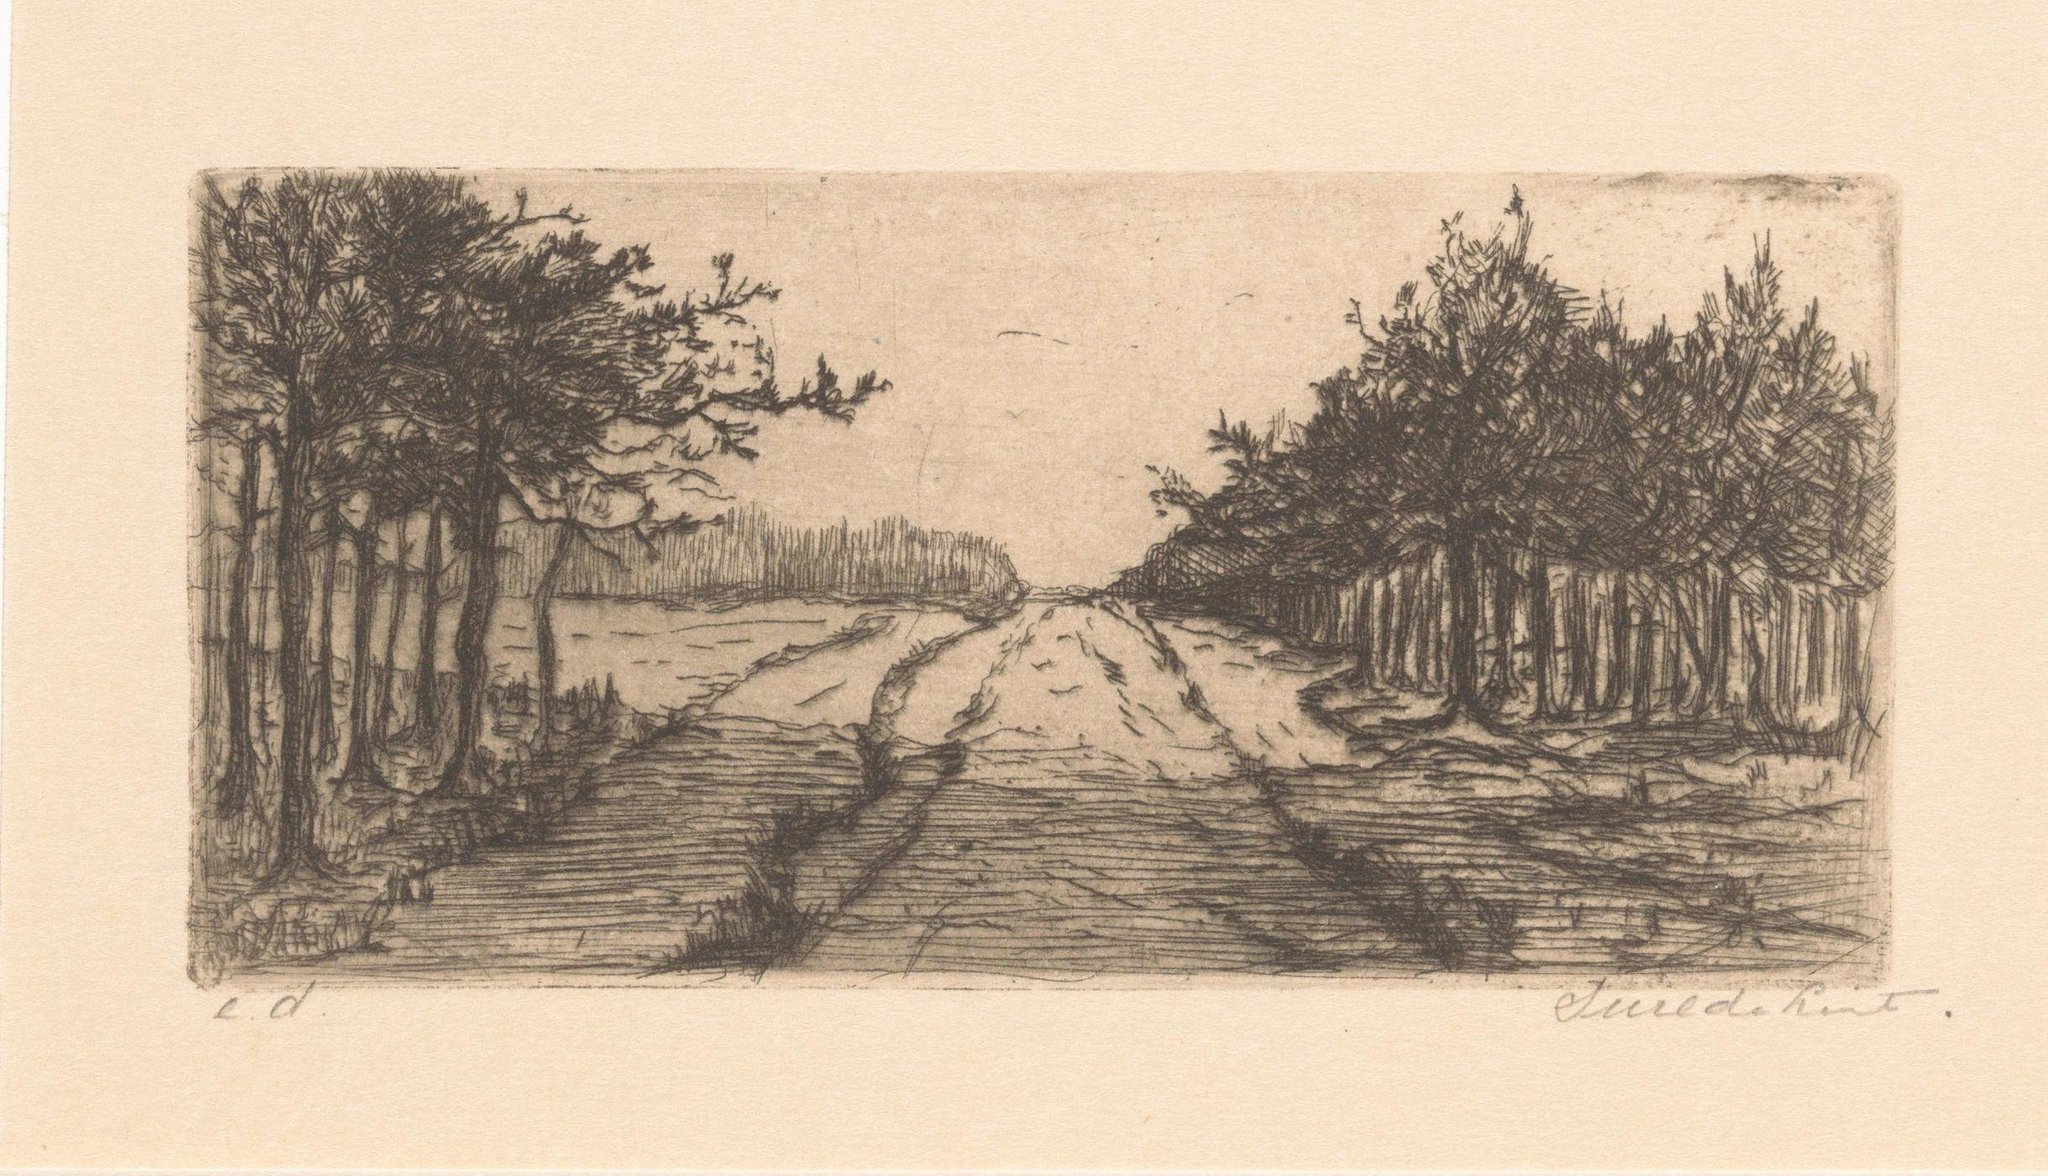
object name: print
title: Landweg bij bosrand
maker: suze de lint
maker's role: print maker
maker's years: 1878-1953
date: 1888-1931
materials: paper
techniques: etching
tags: fringe, edge of the wood, road, path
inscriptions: collector's mark: Lugt 2228